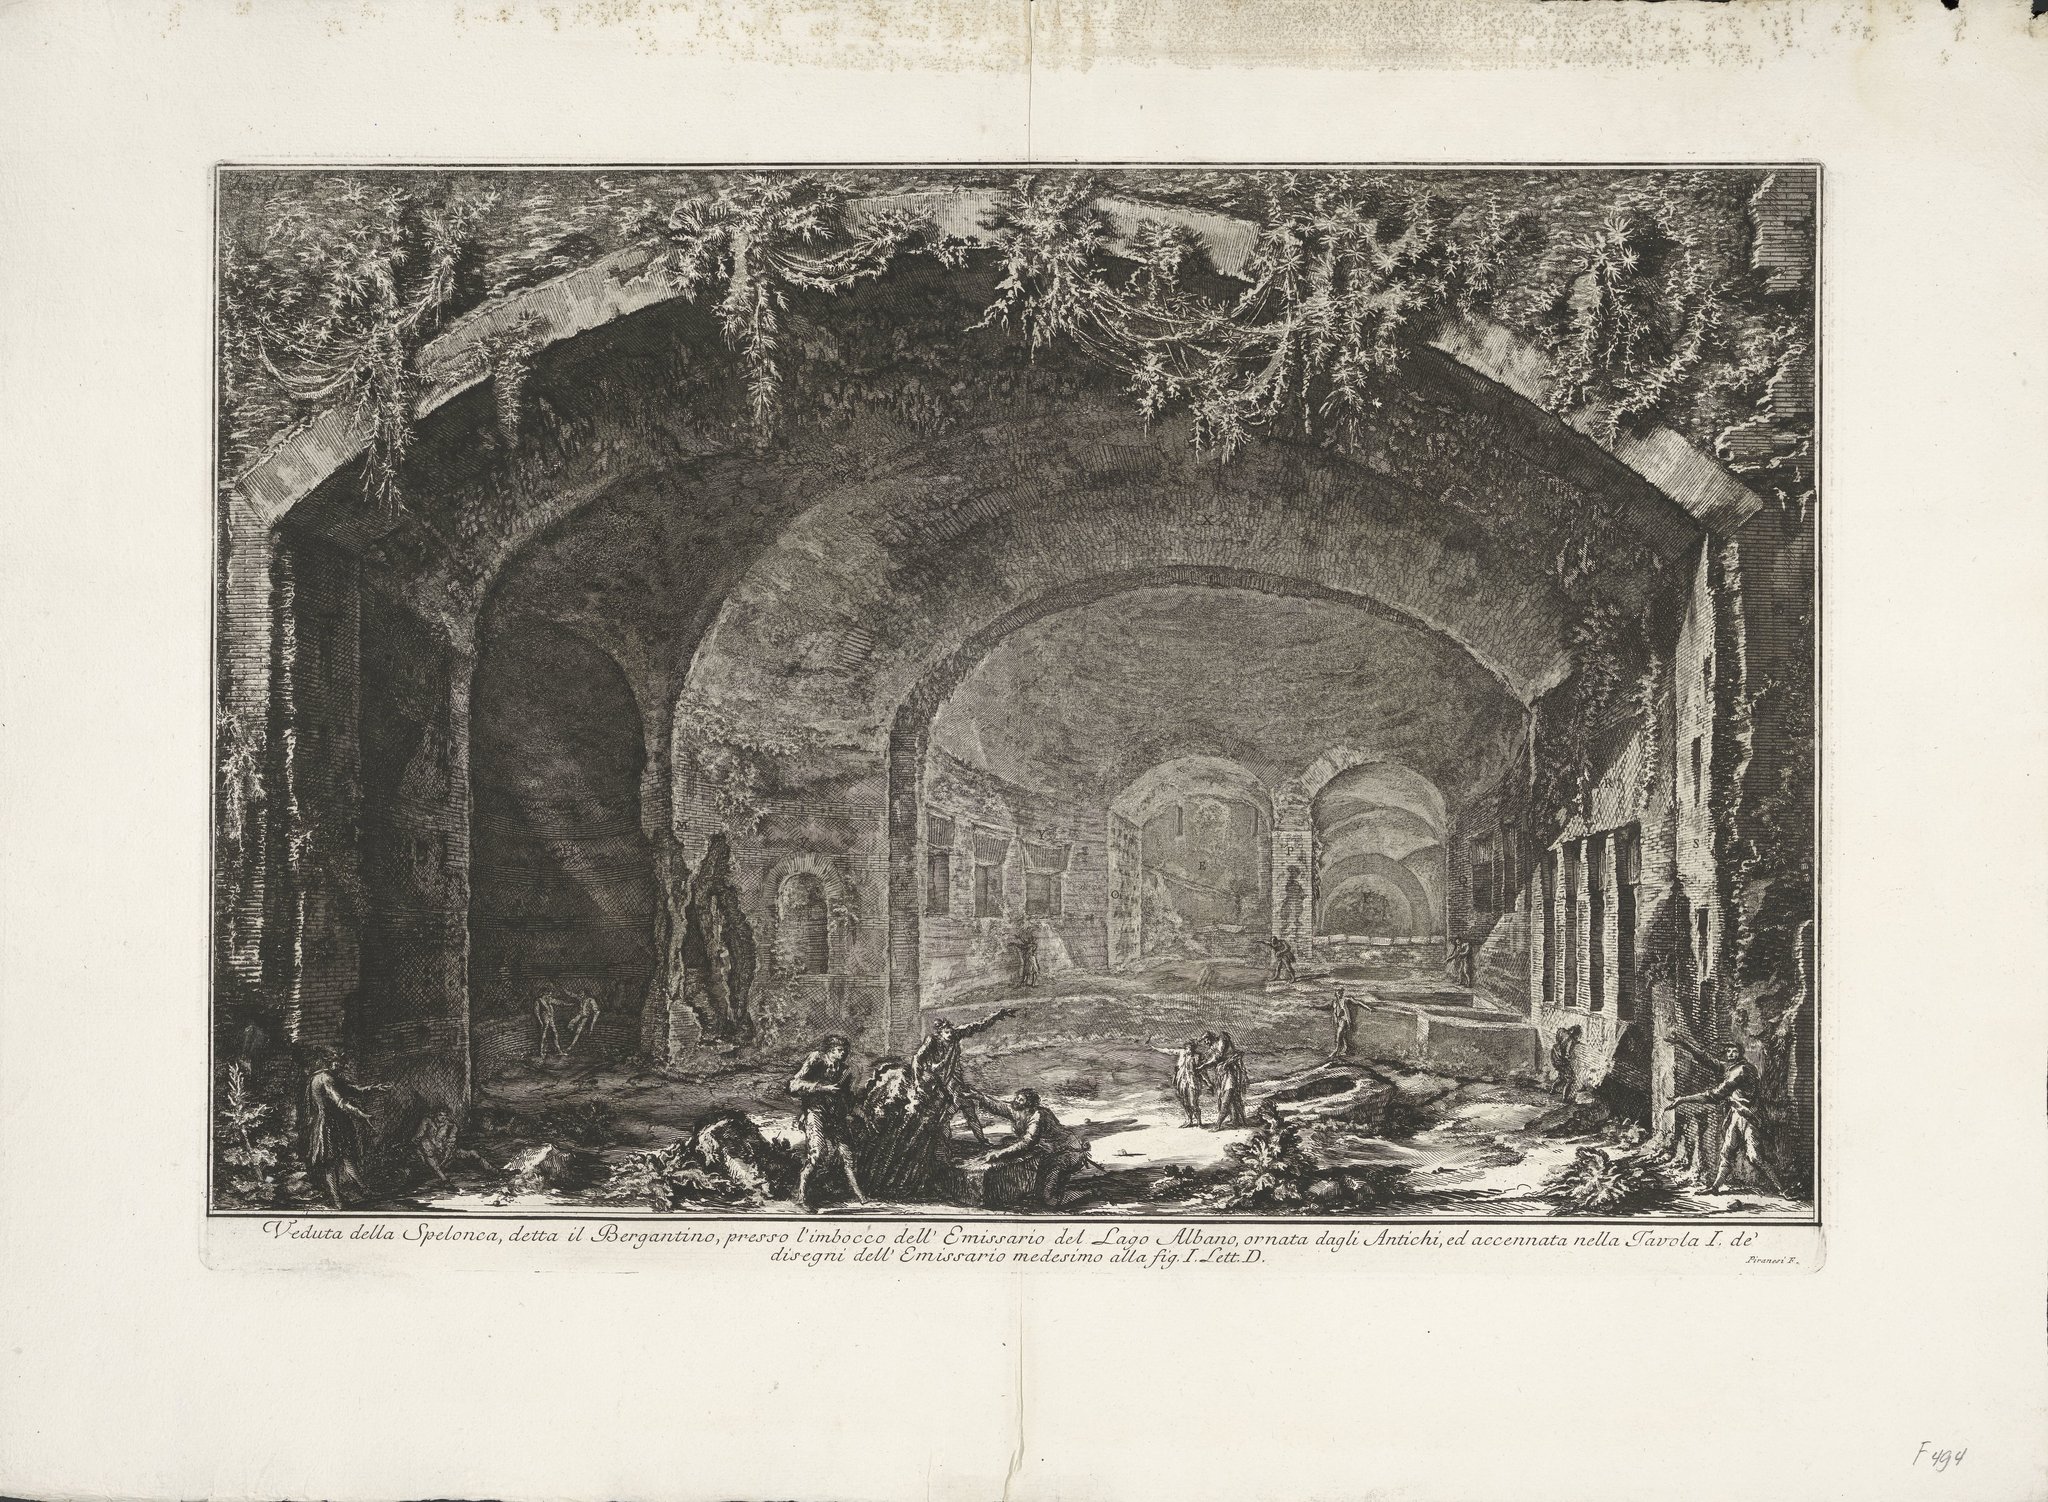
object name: print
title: Twee versierde grotten bij het Meer van Albano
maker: giovanni battista piranesi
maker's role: designer, draughtsman, print maker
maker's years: 1720-1778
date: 1762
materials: paper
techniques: etching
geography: rome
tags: cave, grotto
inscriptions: collector's mark: Lugt 2228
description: Deze prent maakt deel uit van de serie 'Di due spelonche ornate dagli antichi alla Riva del Lago Albano'. De serie bestaat uit een vignet en twaalf prenten.